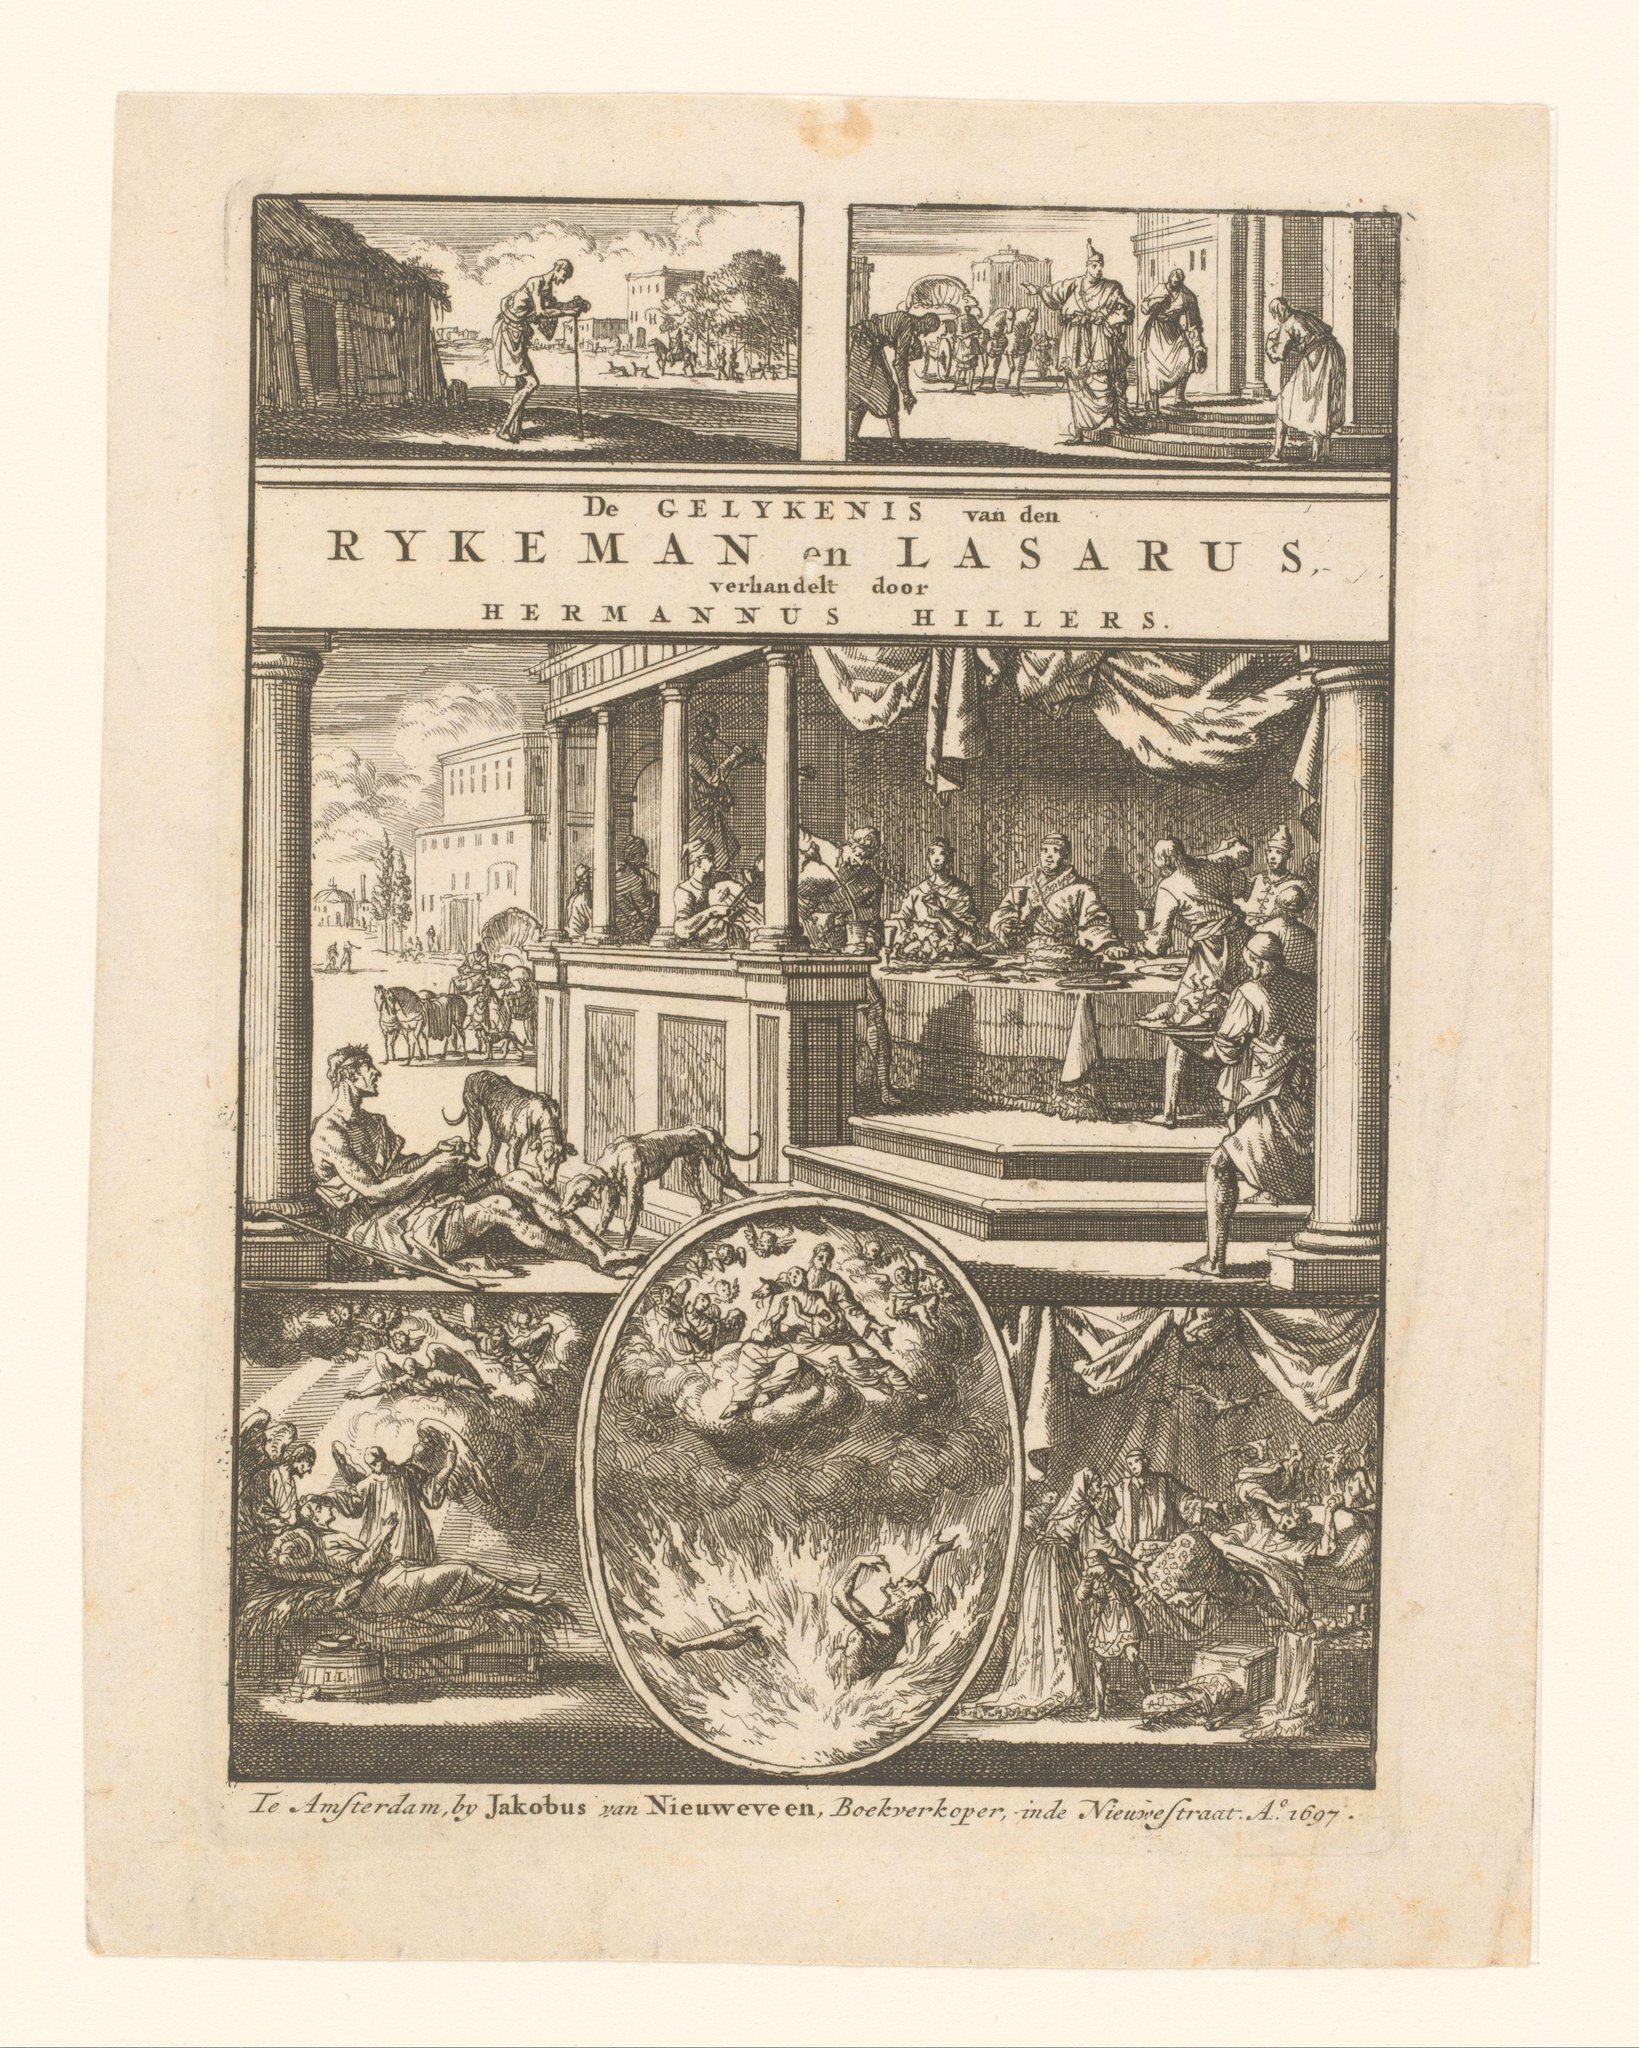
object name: titelblad, titelpagina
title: Titelpagina voor: H. Hillers, De gelykenis van den ryke man en Lazarus, 1698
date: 1697-1698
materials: paper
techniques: etching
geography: amsterdam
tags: dives dies; his soul is brought into hell by devils, the rich man (dives) is feasting, while poor lazarus is starving at the gate (dogs licking lazarus' sores) (luke 16:19-31)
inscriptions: collector's mark: Lugt 240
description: De geschiedenis van Lazarus en de rijke man in één grote en vijf kleine voorstellingen. Als centrale voorstelling is de maaltijd van de rijke man weergegeven.